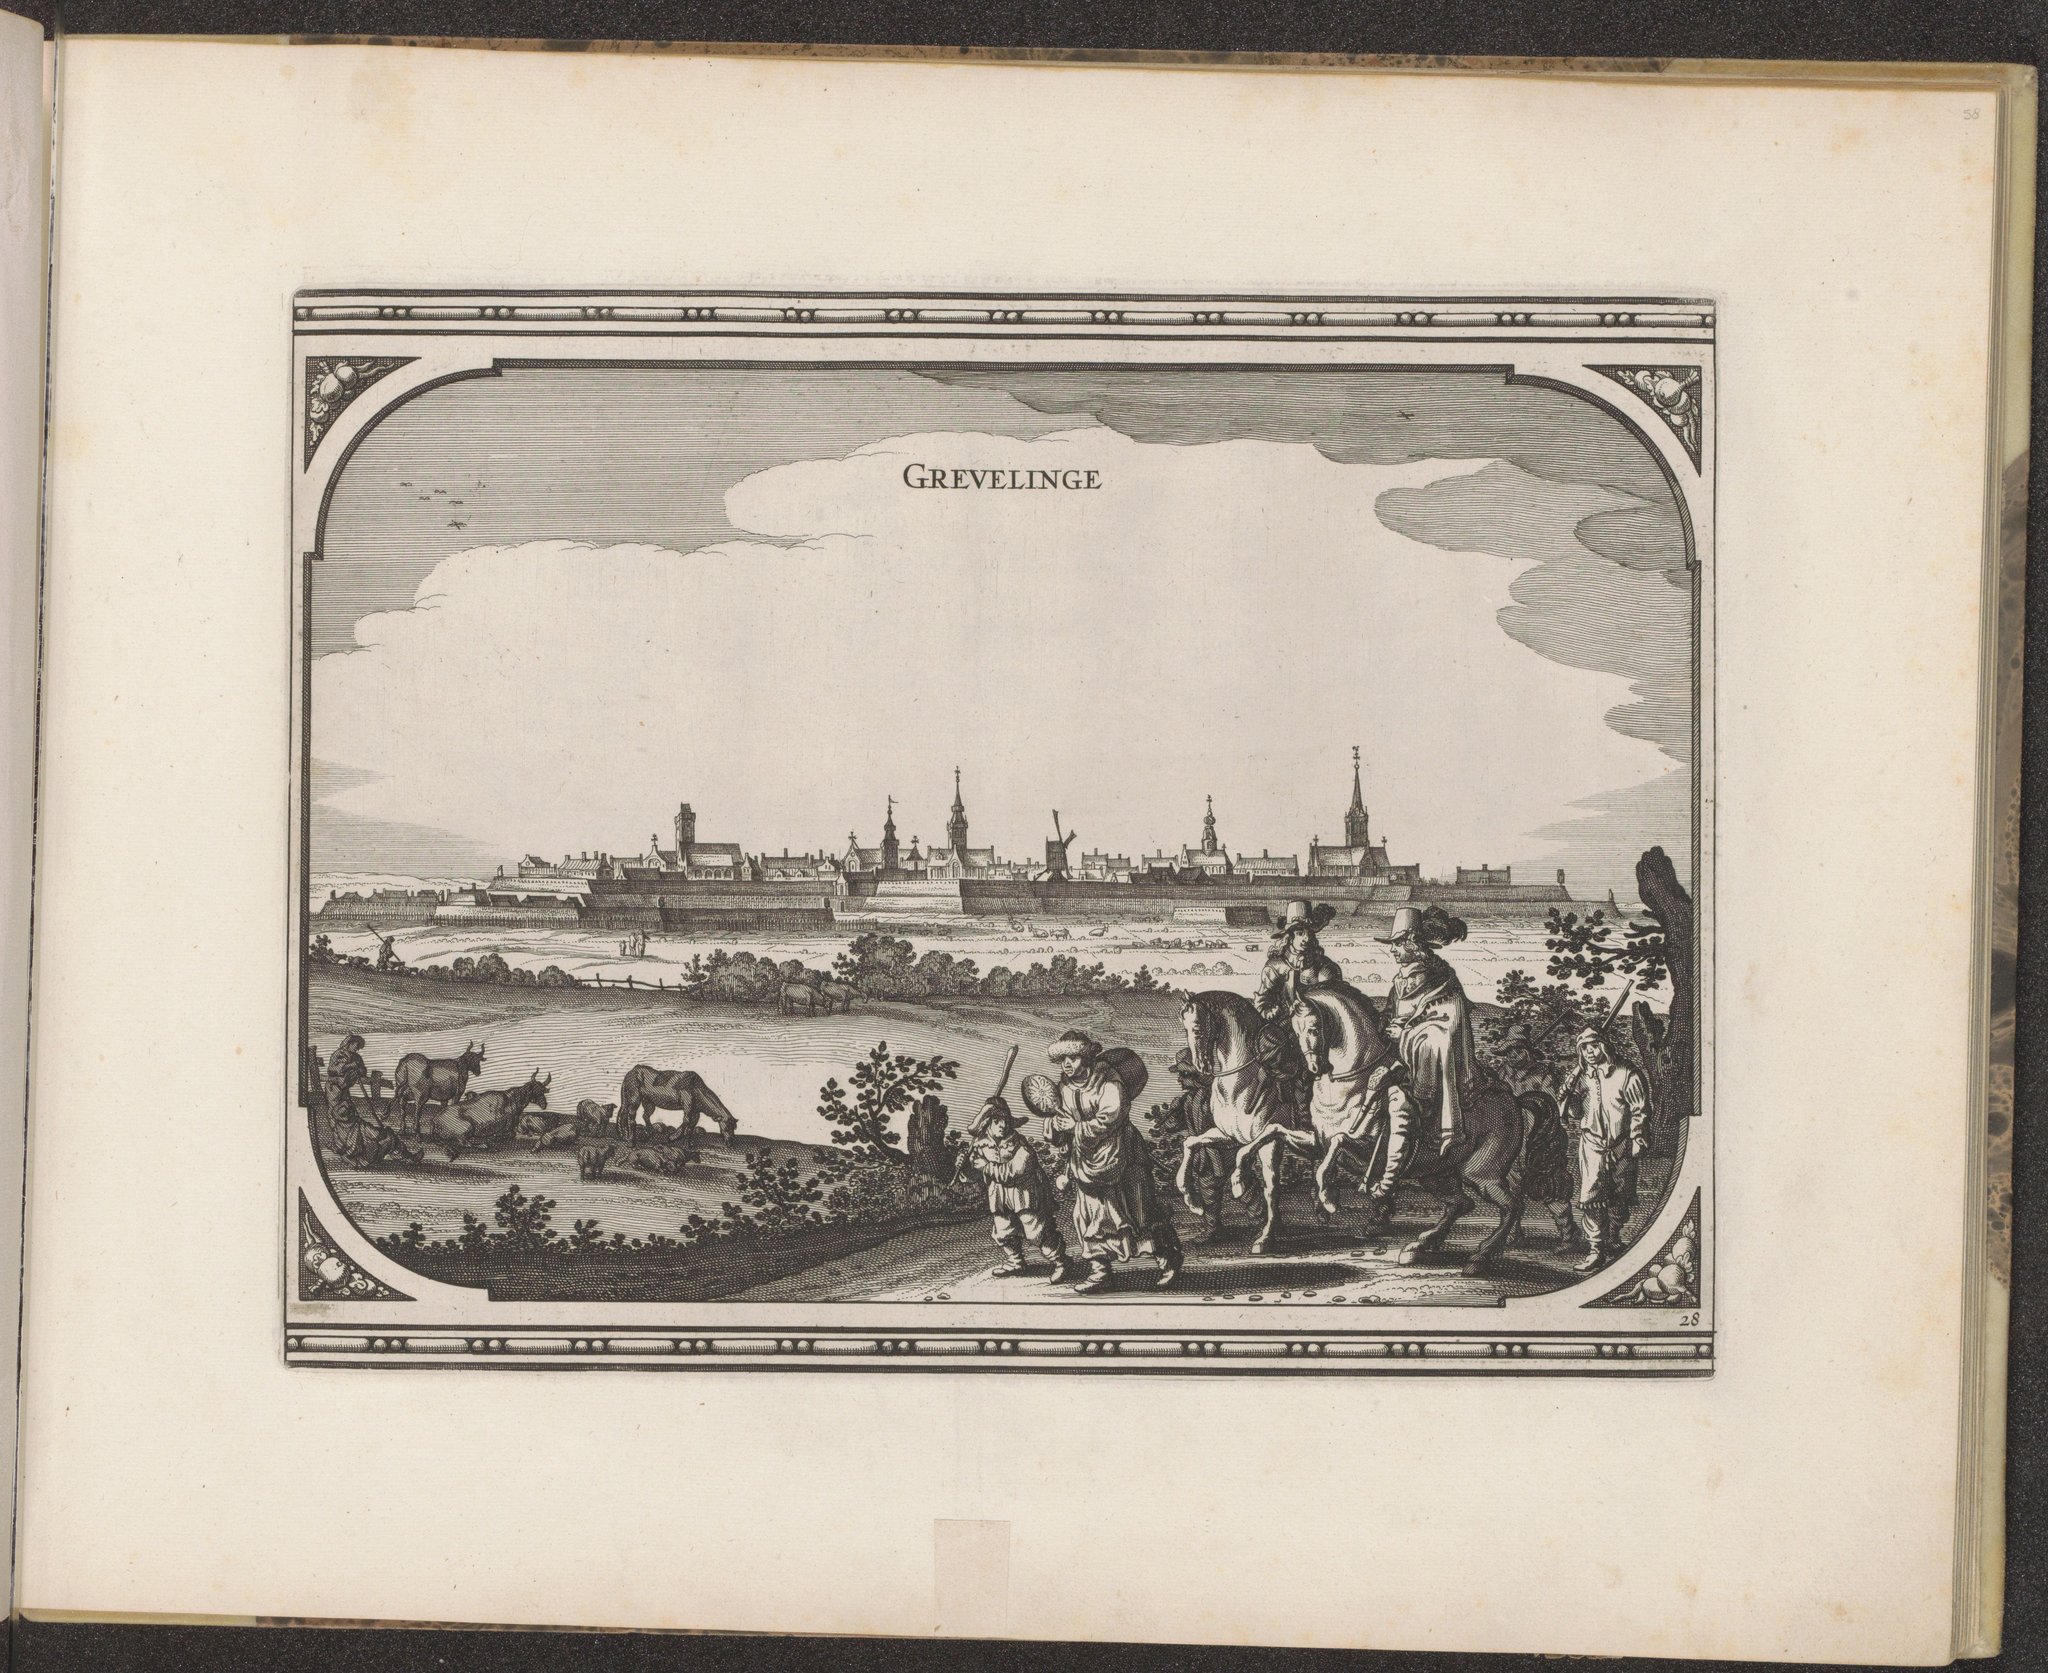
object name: album leaf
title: Grevelinge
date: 1660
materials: paper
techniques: etching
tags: riding a horse, ass, or mule; rider, horseman, city-view, and landscape with man-made constructions, herding, herdsman, herdswoman, shepherd, shepherdess, cowherd, etc.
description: Gezicht op de stad Grevelingen. Op de voorgrond rechts twee heren te paard en twee mannen met een geweer. Links twee herders met hun kudde. De prent maakt deel uit van een album.